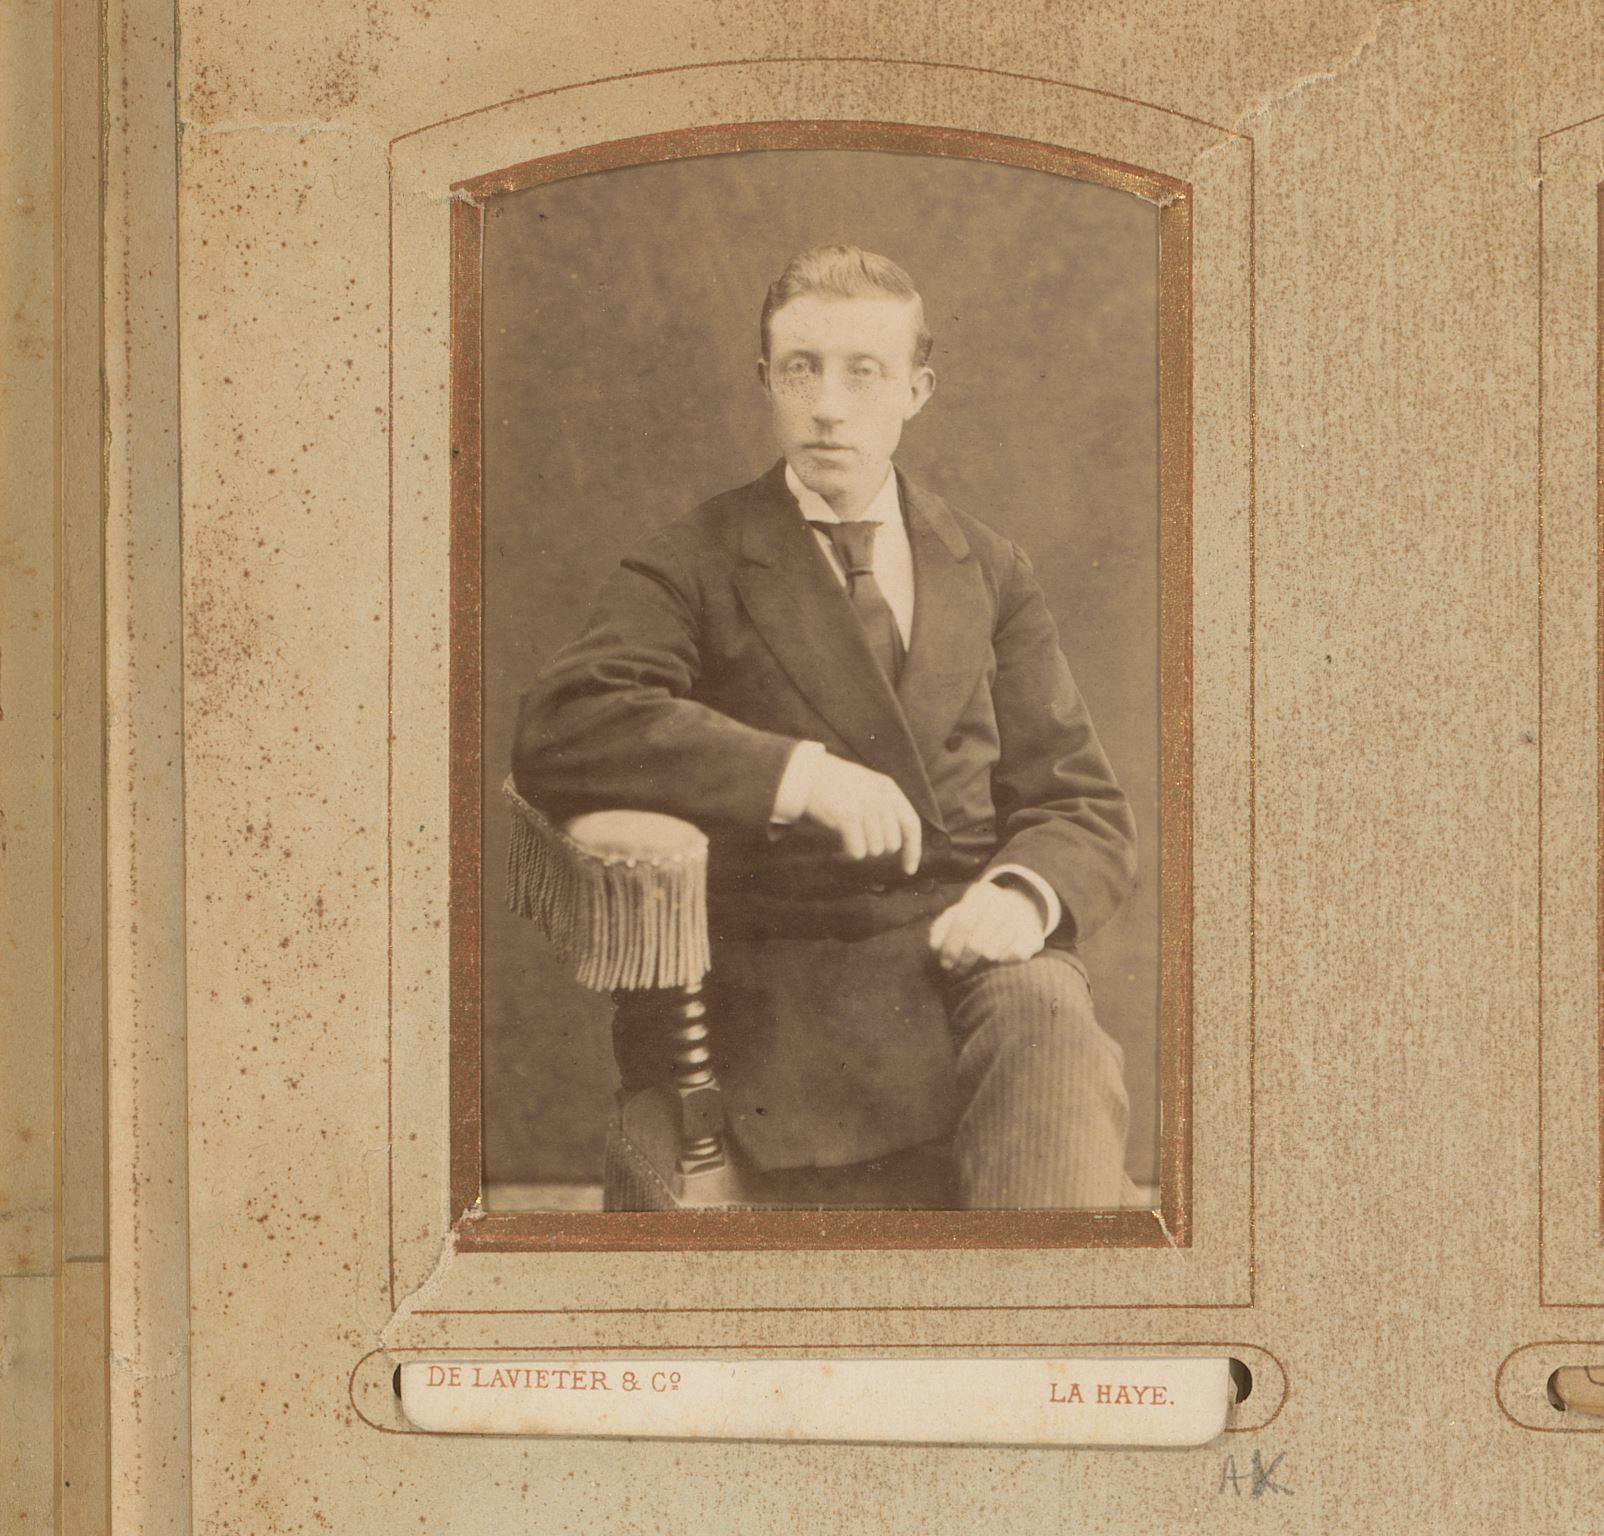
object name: album leaf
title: Portret van een zittende jonge man met stropdas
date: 1876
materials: cardboard, photographic support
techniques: albumen print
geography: the hague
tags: sitting figure, historical persons, youth, adolescent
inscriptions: inscription: ‘De Lavieter & Co./ Photographes/ Willemstraat No. 2/ La Haye.’